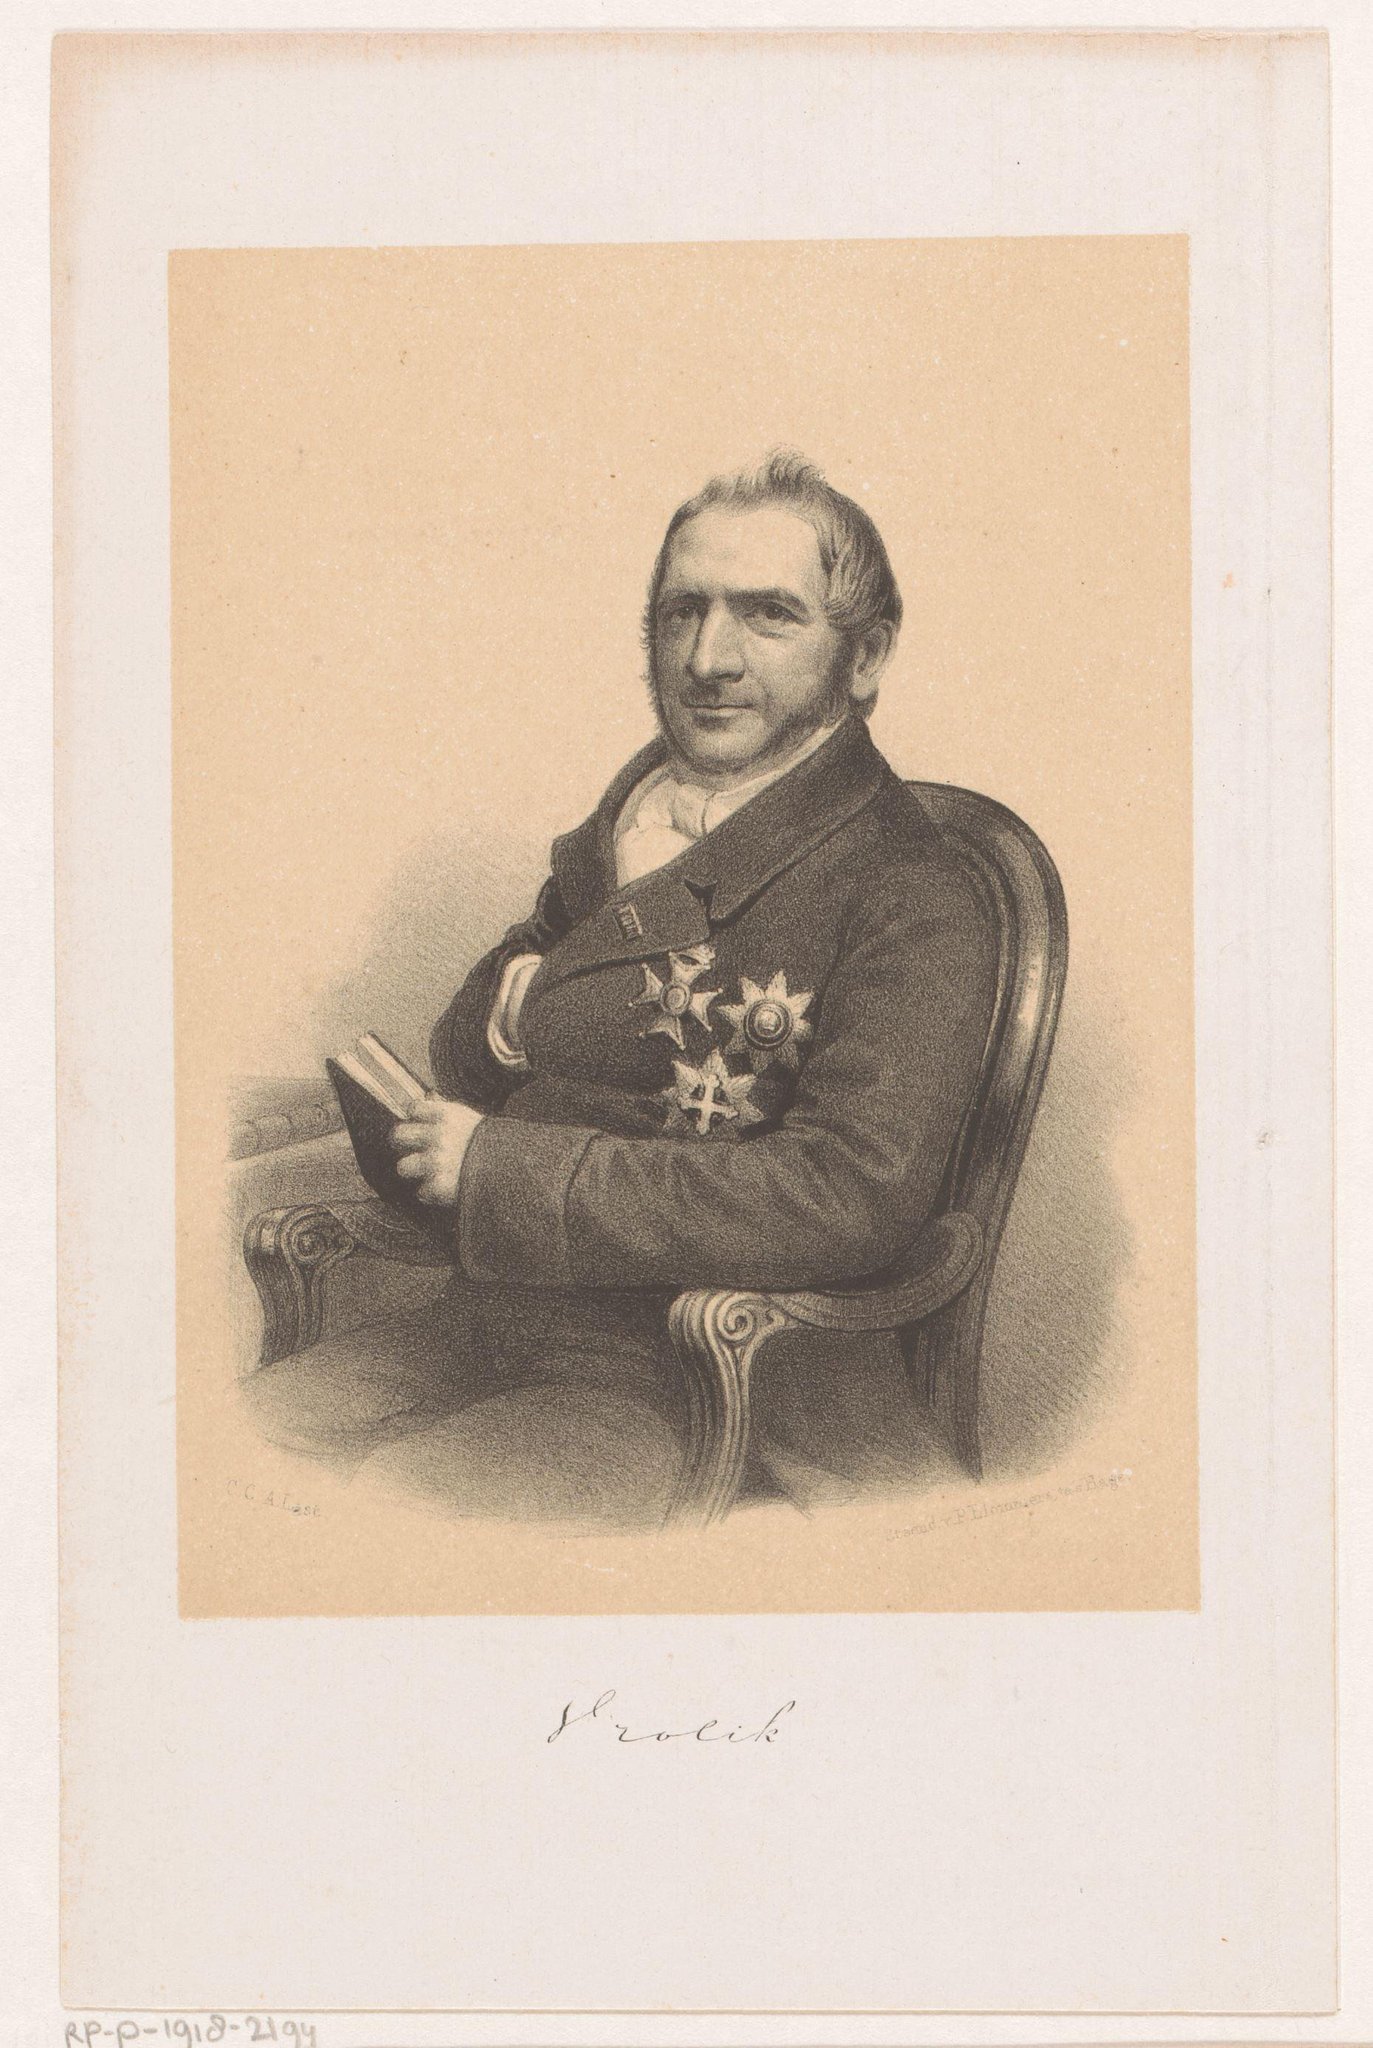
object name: print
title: Portret van Willem Cornelis Ackersdijck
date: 1843-1844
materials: paper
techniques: lithograph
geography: rotterdam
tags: den bosch, rotterdam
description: Portret van Willem Cornelis Ackersdijck. Hij zit in een stoel. In de ondermarge zijn handtekening, zijn geboorteplaats en geboortedatum, zijn sterfplaats en sterfdatum